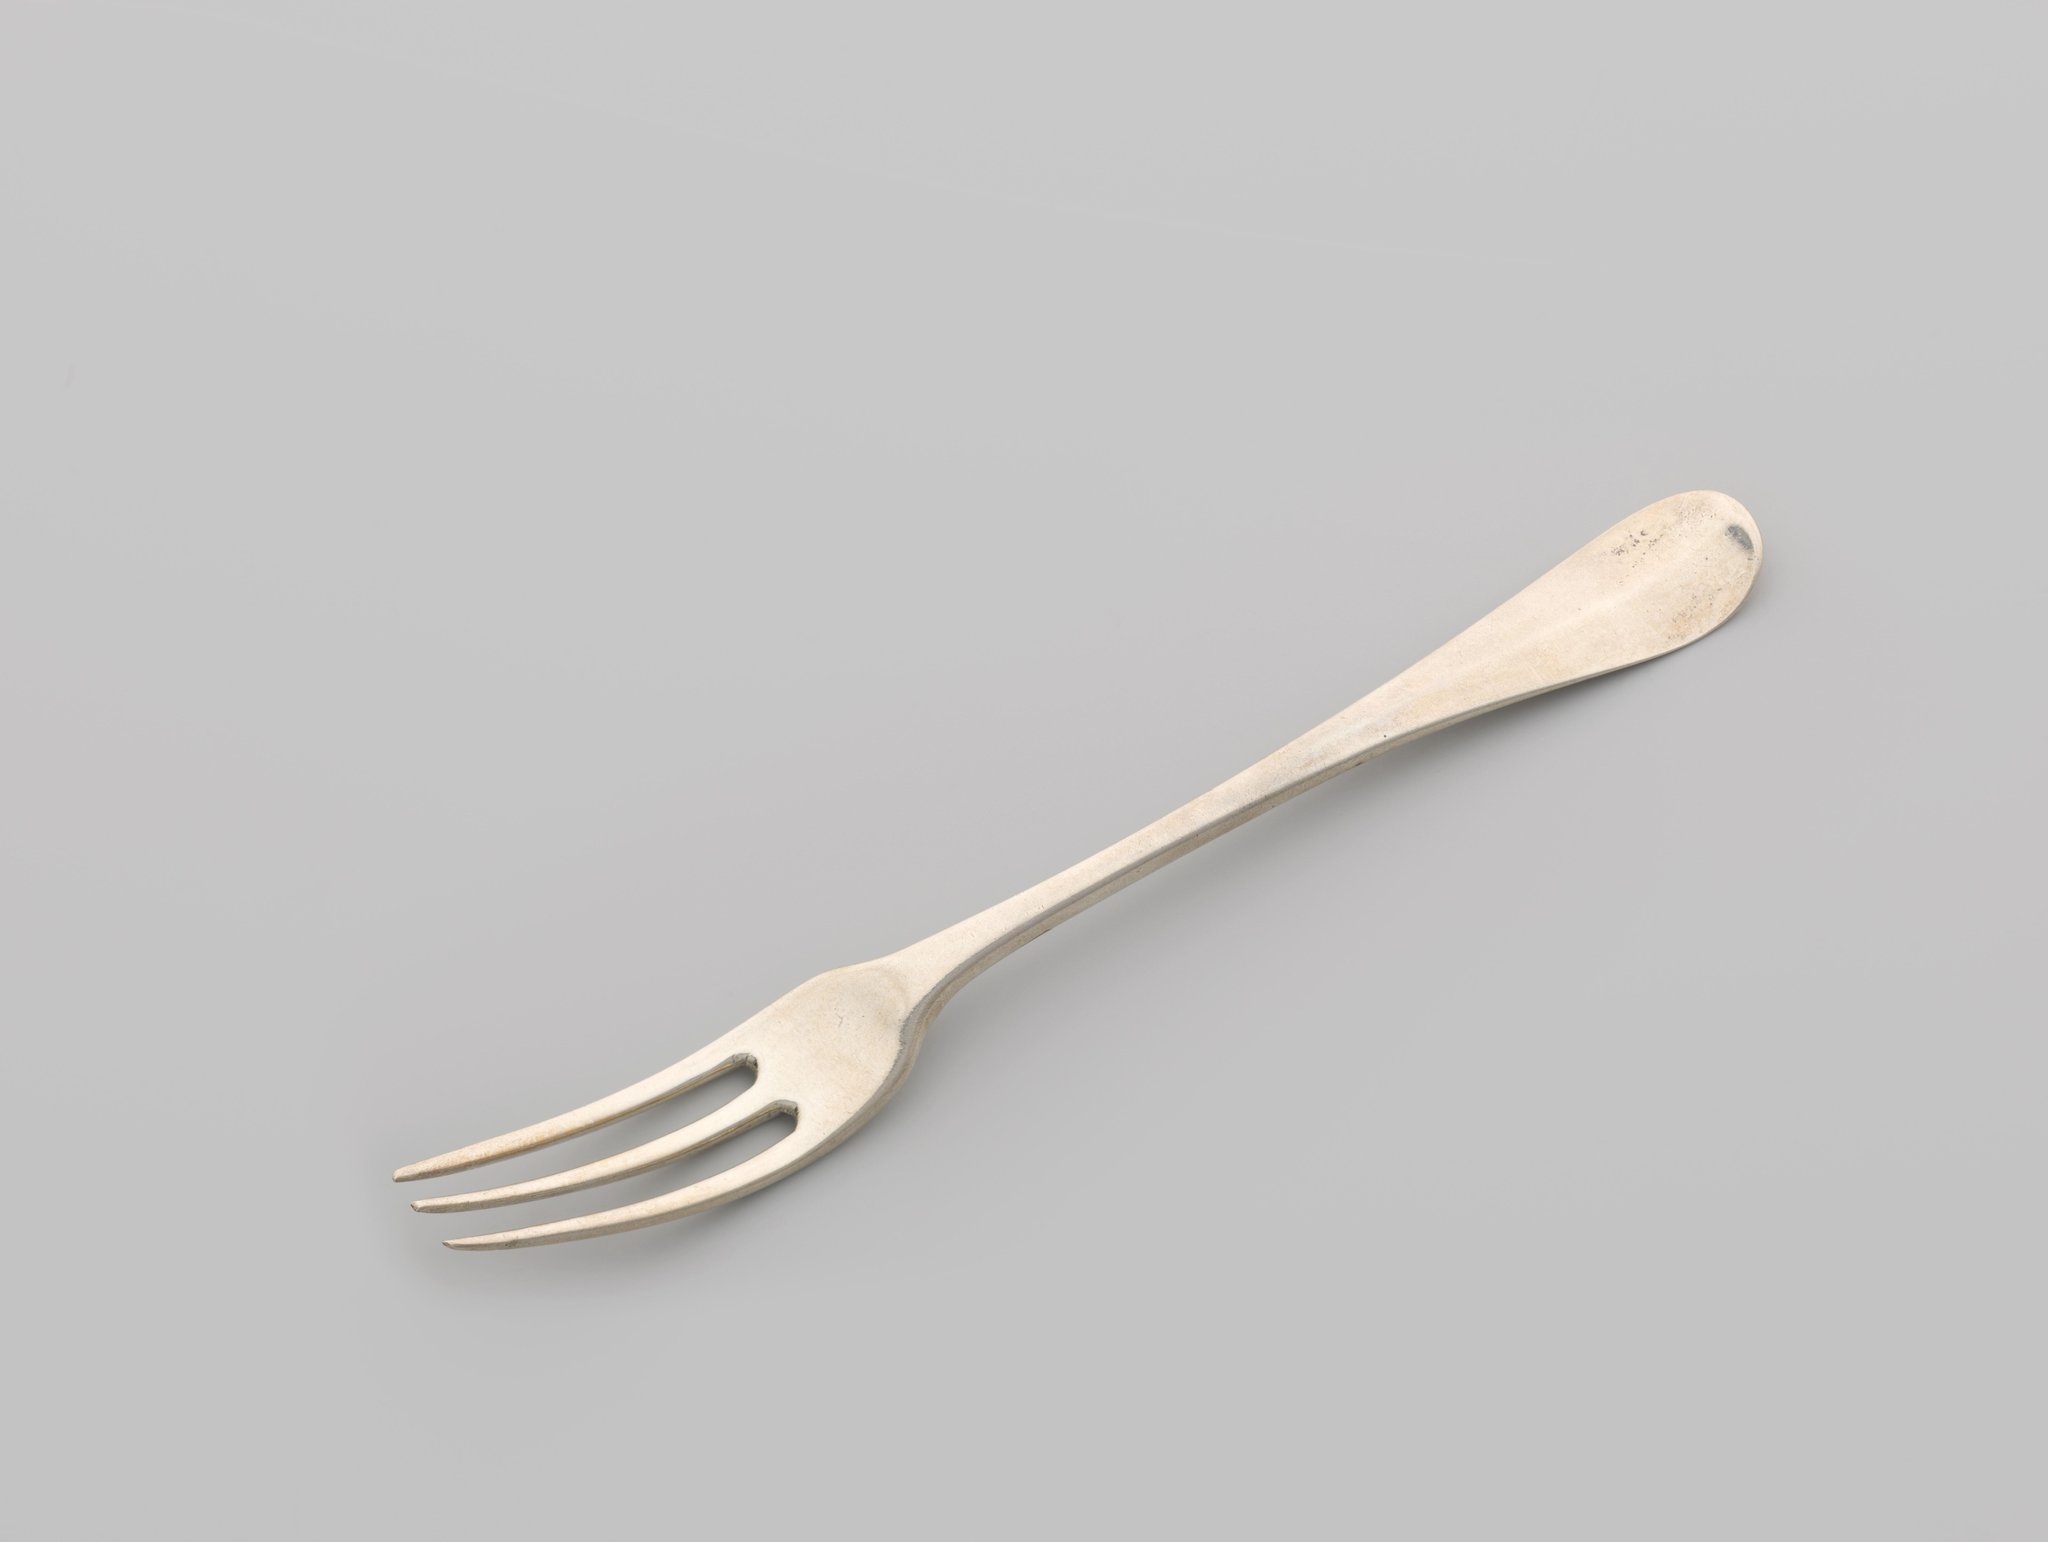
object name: dessert fork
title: Dessertvork met het helmteken Clifford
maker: roelof helweg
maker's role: silversmith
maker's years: 1758-1843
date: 1800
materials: silver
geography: amsterdam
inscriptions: date letter: ‘I’, town mark, maker's mark, alloy mark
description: De drietandige vork is door middel van enkel lof verbonden met de platte, gebogen steel, die zich verbreedt naar het afgeronde uiteinde en die aan de bovenzijde over het midden een flauwe ribbel vertoont. Op de onderzijde van de steel is het helmteken Clifford gegraveerd.